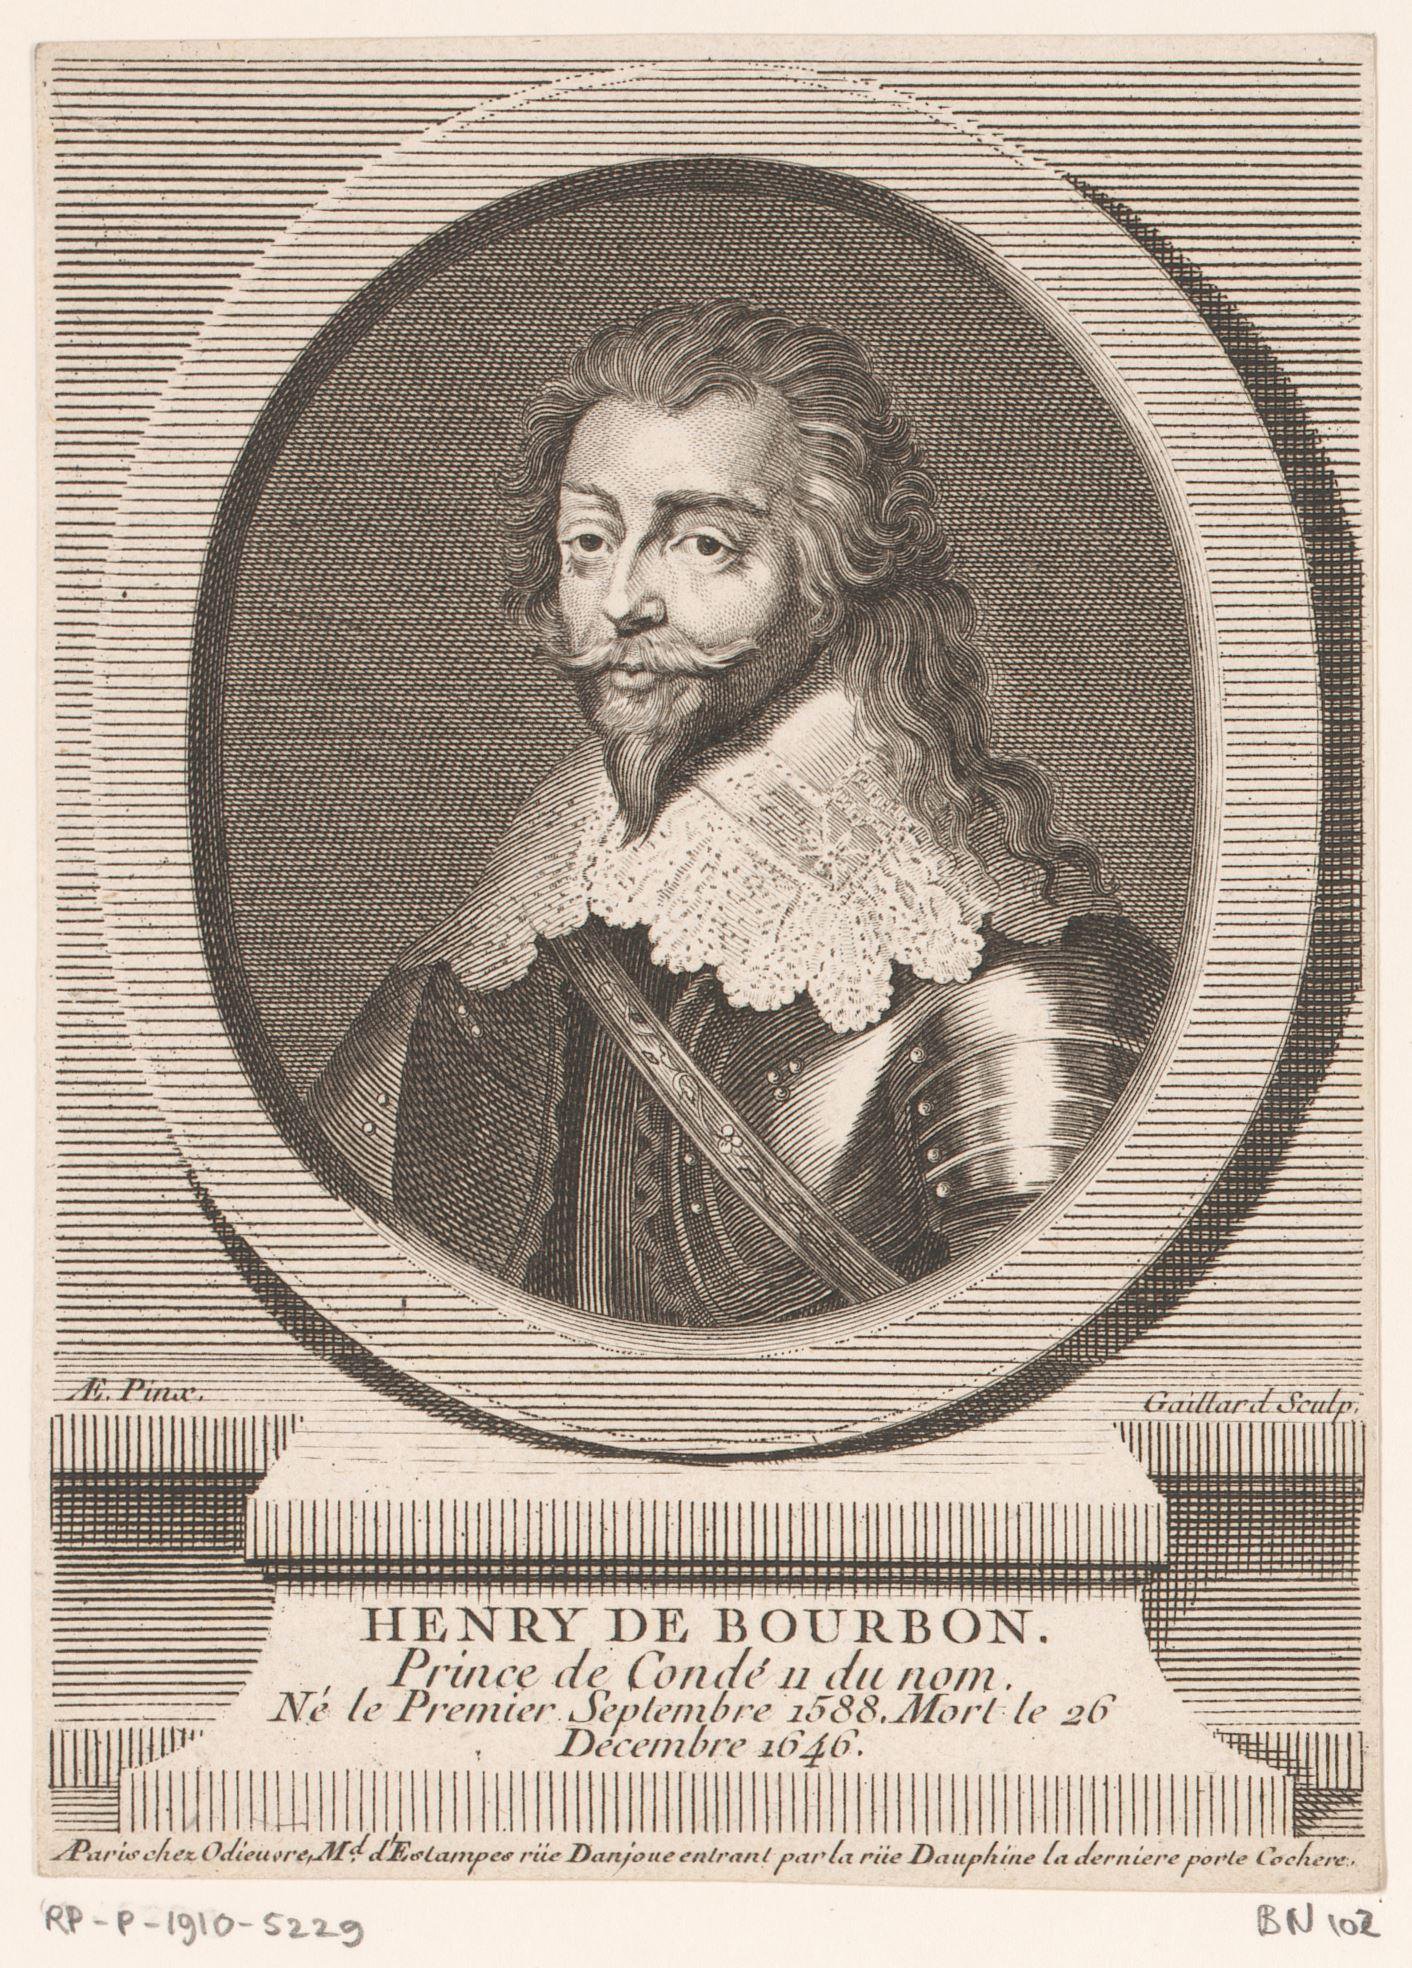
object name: print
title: Portret van Henri II de Bourbon-Condé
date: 1745-1765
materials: paper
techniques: engraving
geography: paris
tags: paris, henri (prince of condé), historical persons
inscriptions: collector's mark: Lugt 2228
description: Mogelijk prent uit: Dreux du Radier, Jean-François. L'Europe illustré, contenant l'histoire abregée des souverains, des princes, des prélats, des ministres, (...) en Europe: dans le XVe. siècle compris, jusqu'à présent. Parijs: Michel Odieuvre en André-François Le Breton, 1755-1765, dl. 3.